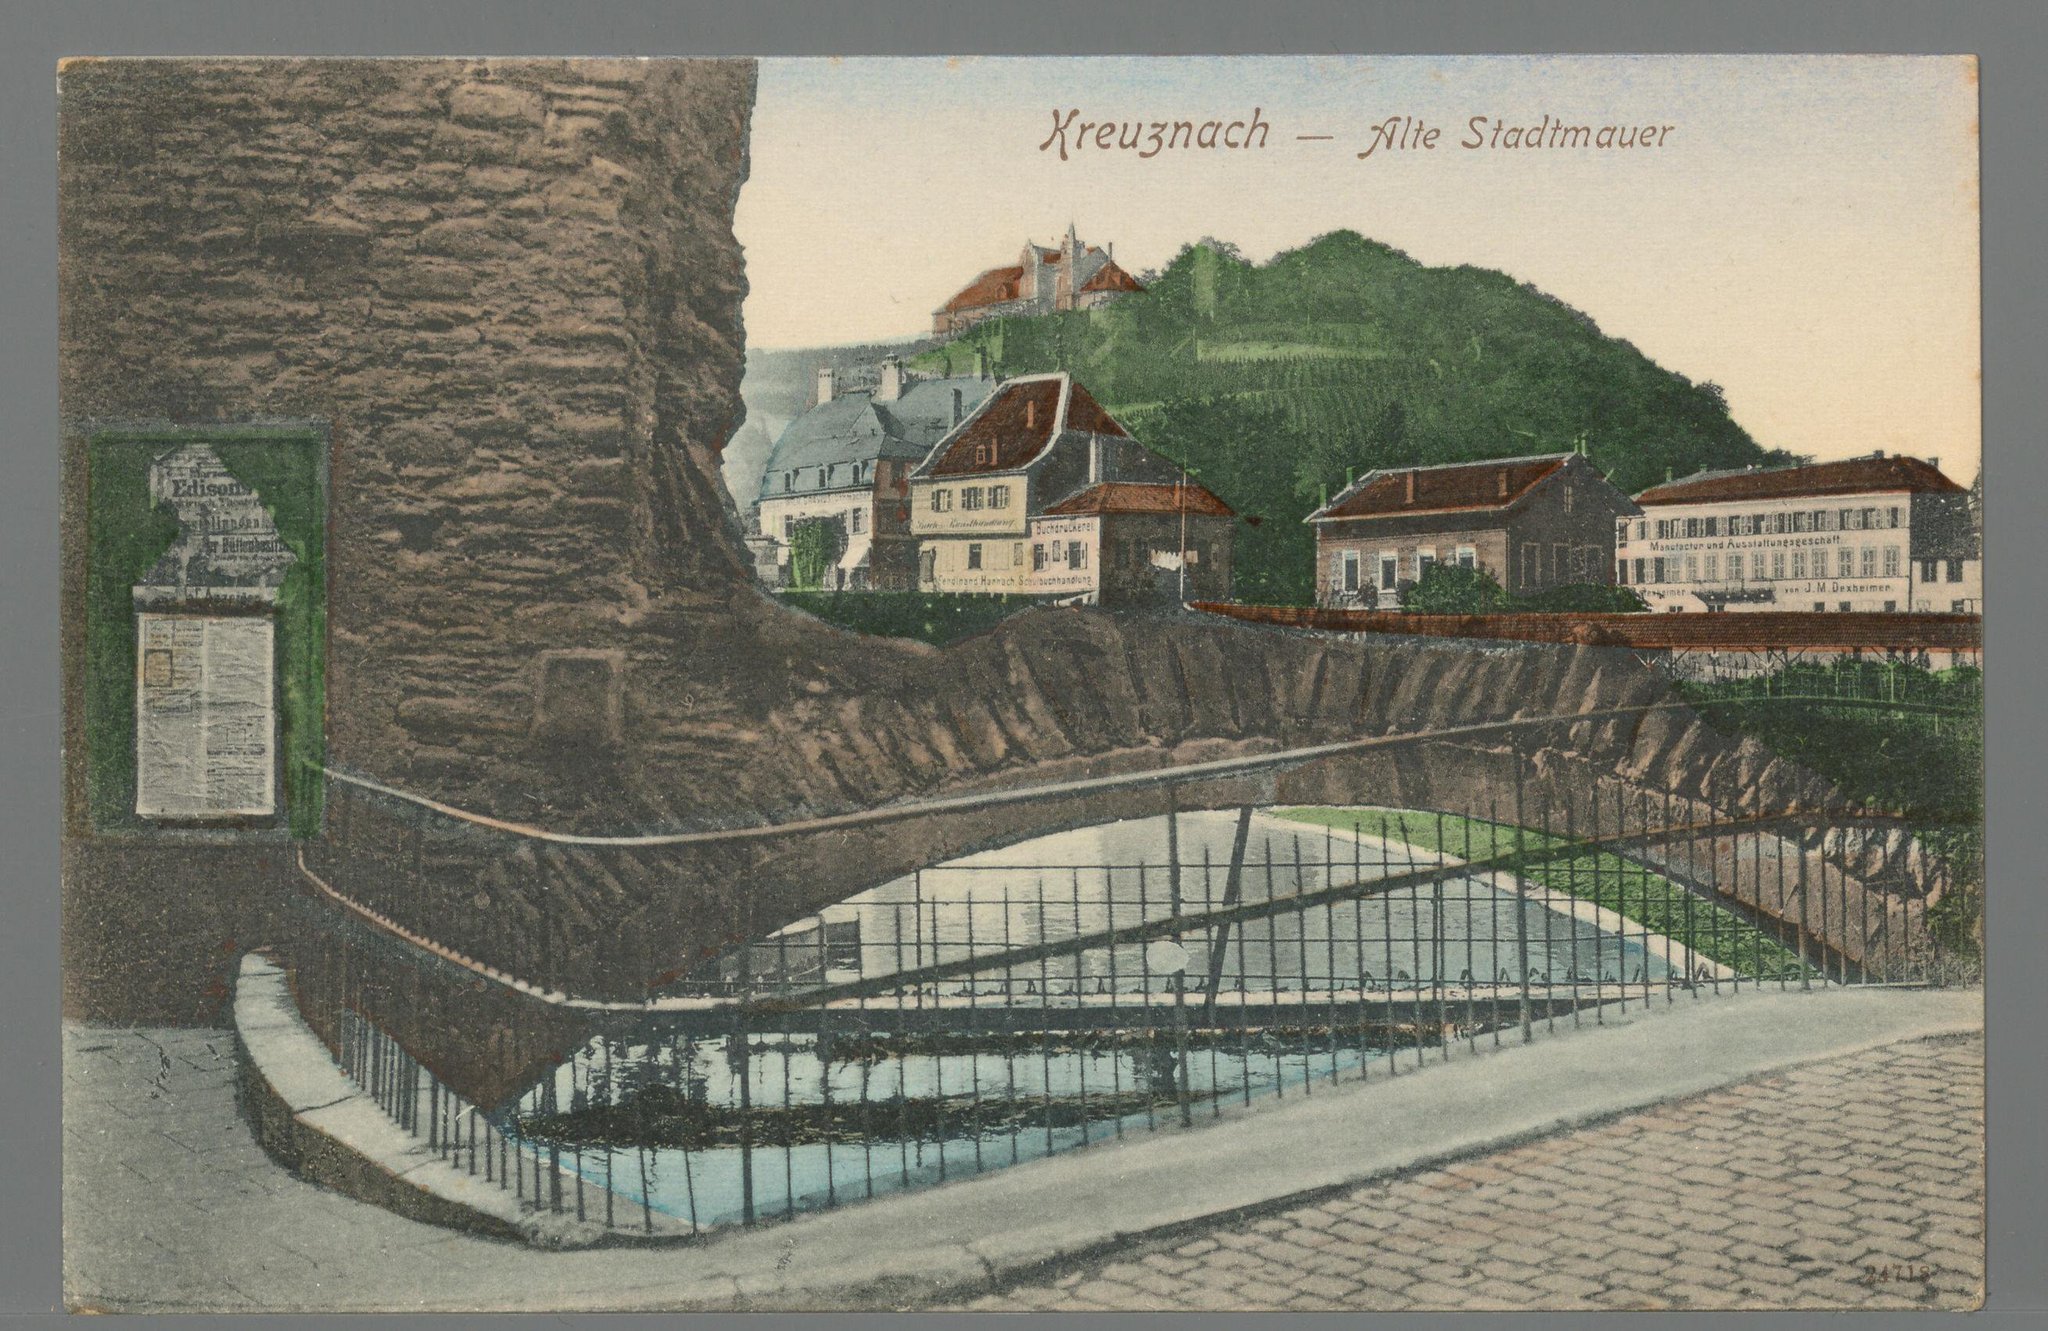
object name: photomechanical print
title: Kreuznach - Alte Stadtmauer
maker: Anonymous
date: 1907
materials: cardboard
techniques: photograph, lithograph, hand coloring, writing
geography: bad kreuznach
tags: city-walls, canals, waters (in city), bridge in city across river, canal, etc.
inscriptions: date